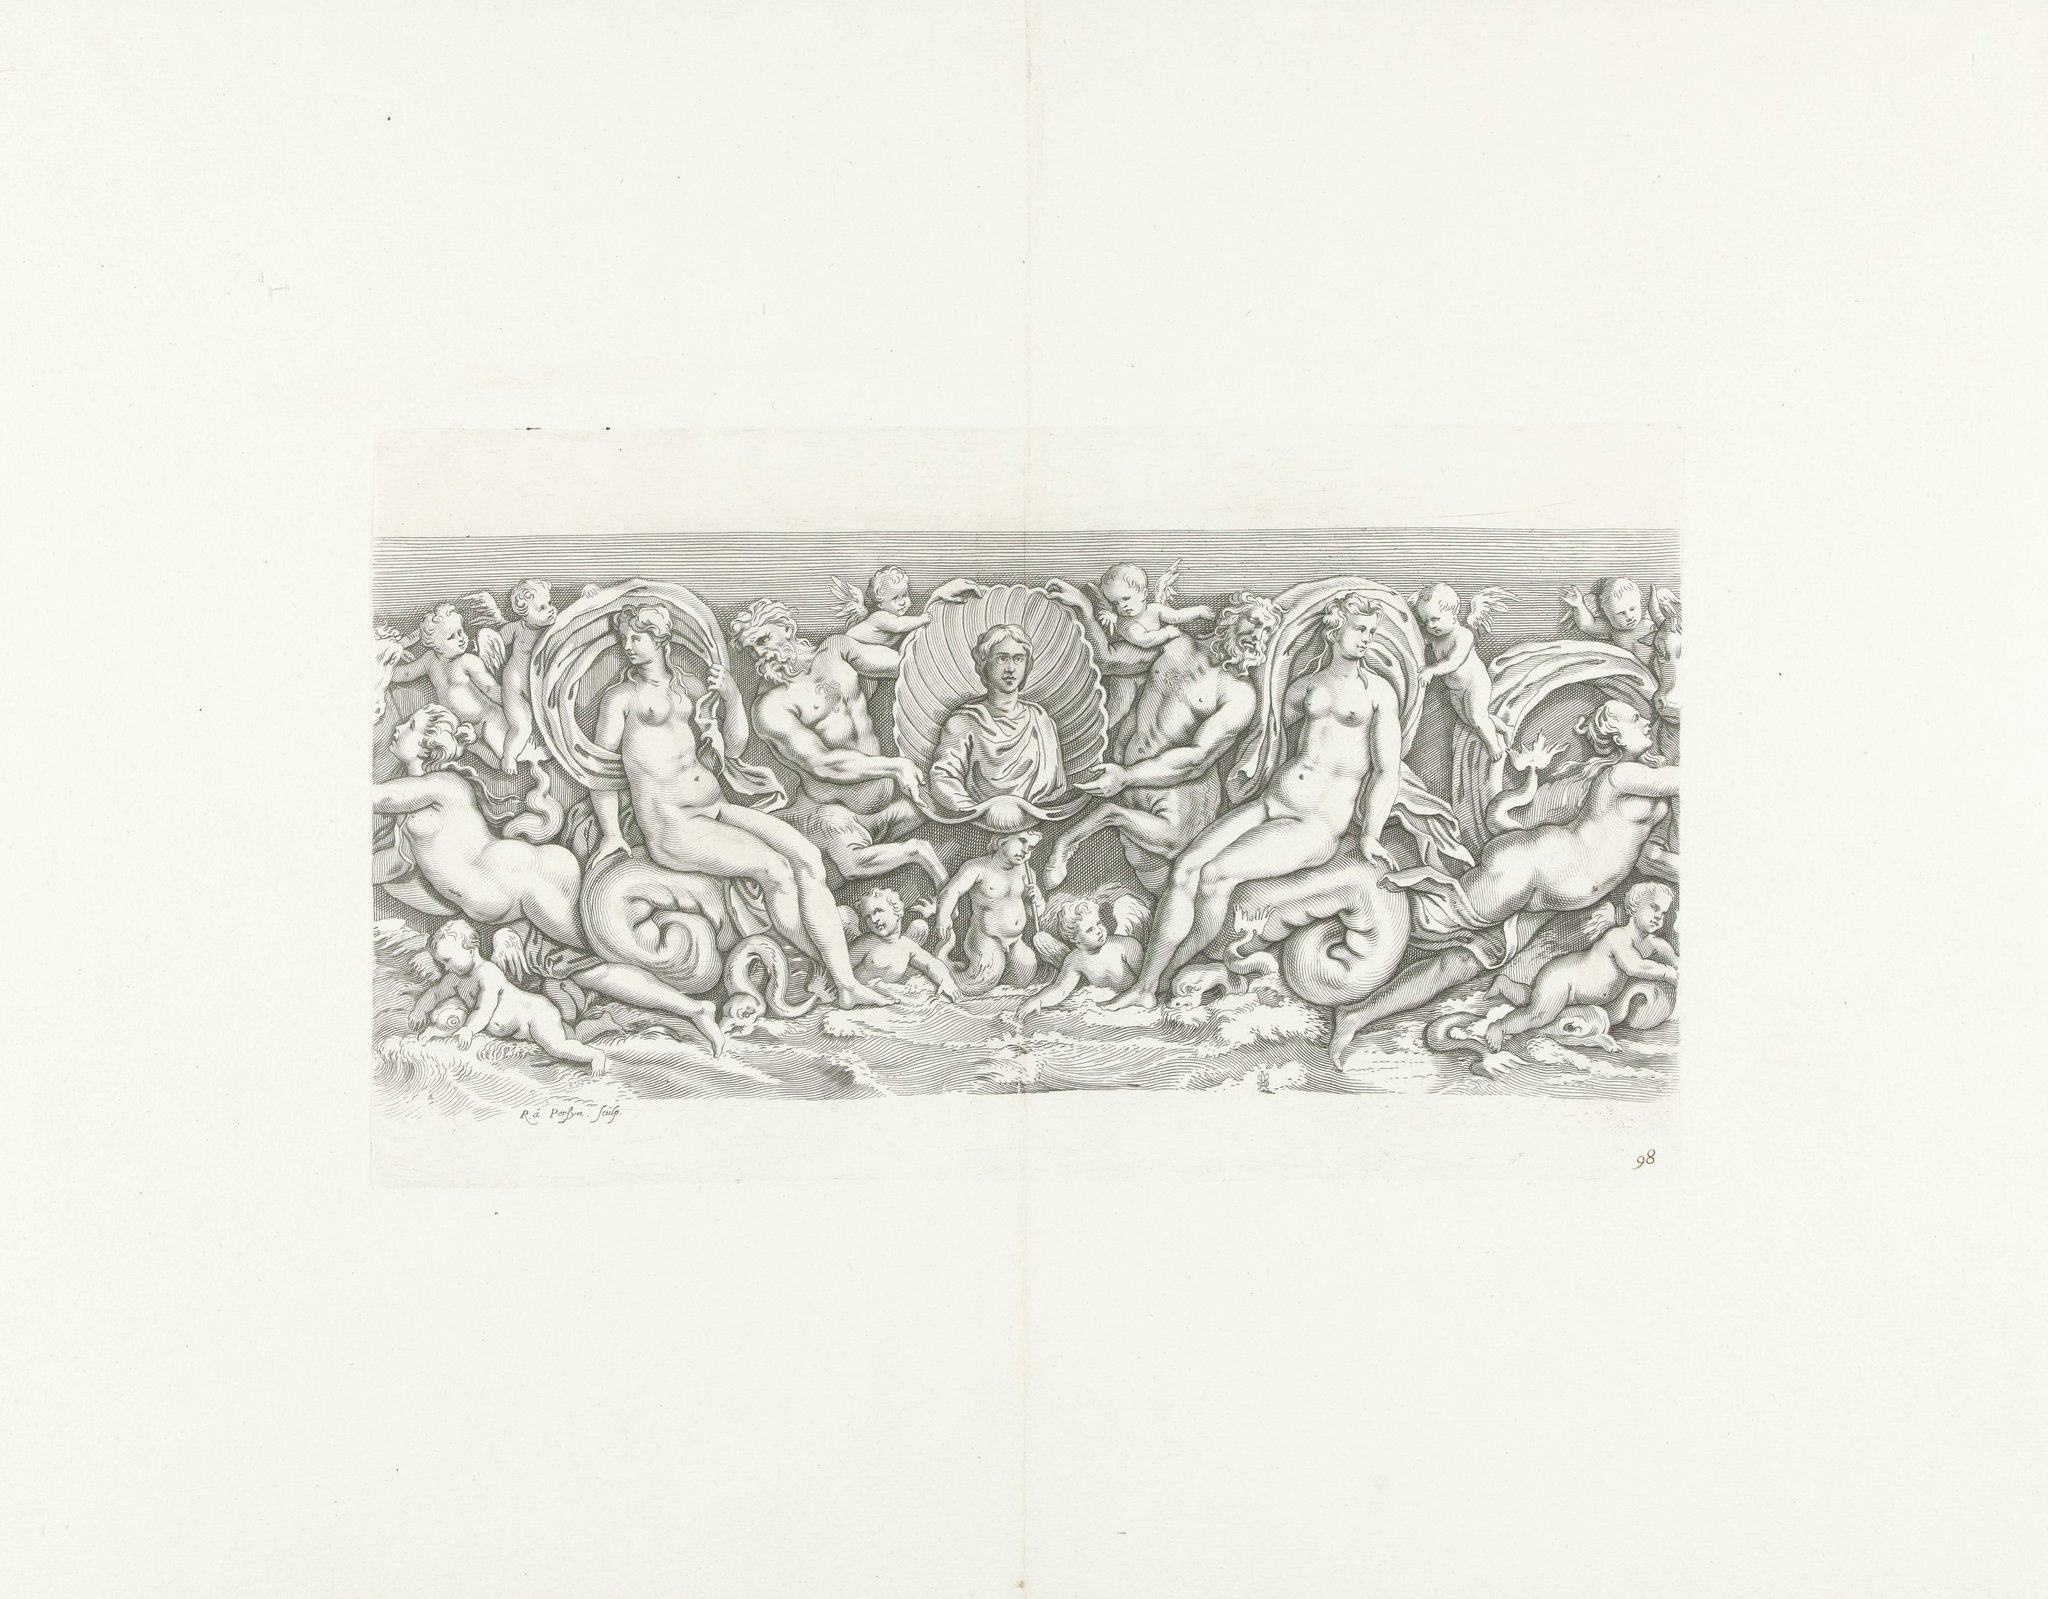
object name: print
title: Bas-reliëf van een sarcofaag met zeenimfen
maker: reinier van persijn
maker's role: draughtsman, painter, print maker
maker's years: 1614-1668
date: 1640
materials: paper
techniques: engraving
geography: rome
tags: vincenzo giustiniani (1564-1637), piece of sculpture, reproduction of a piece of sculpture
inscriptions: number: ‘98’, collector's mark: Lugt 2228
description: Romeins bas-reliëf van een sarcofaag met zeenimfen en in het midden het portret van een vrouw in een schelp. Rechtsonder het wapenschild van Vincenzo Giustiniani. Prent uit een publicatie met reproductieprenten naar de sculpturen in de verzameling in de Galleria Giustiniani te Rome.